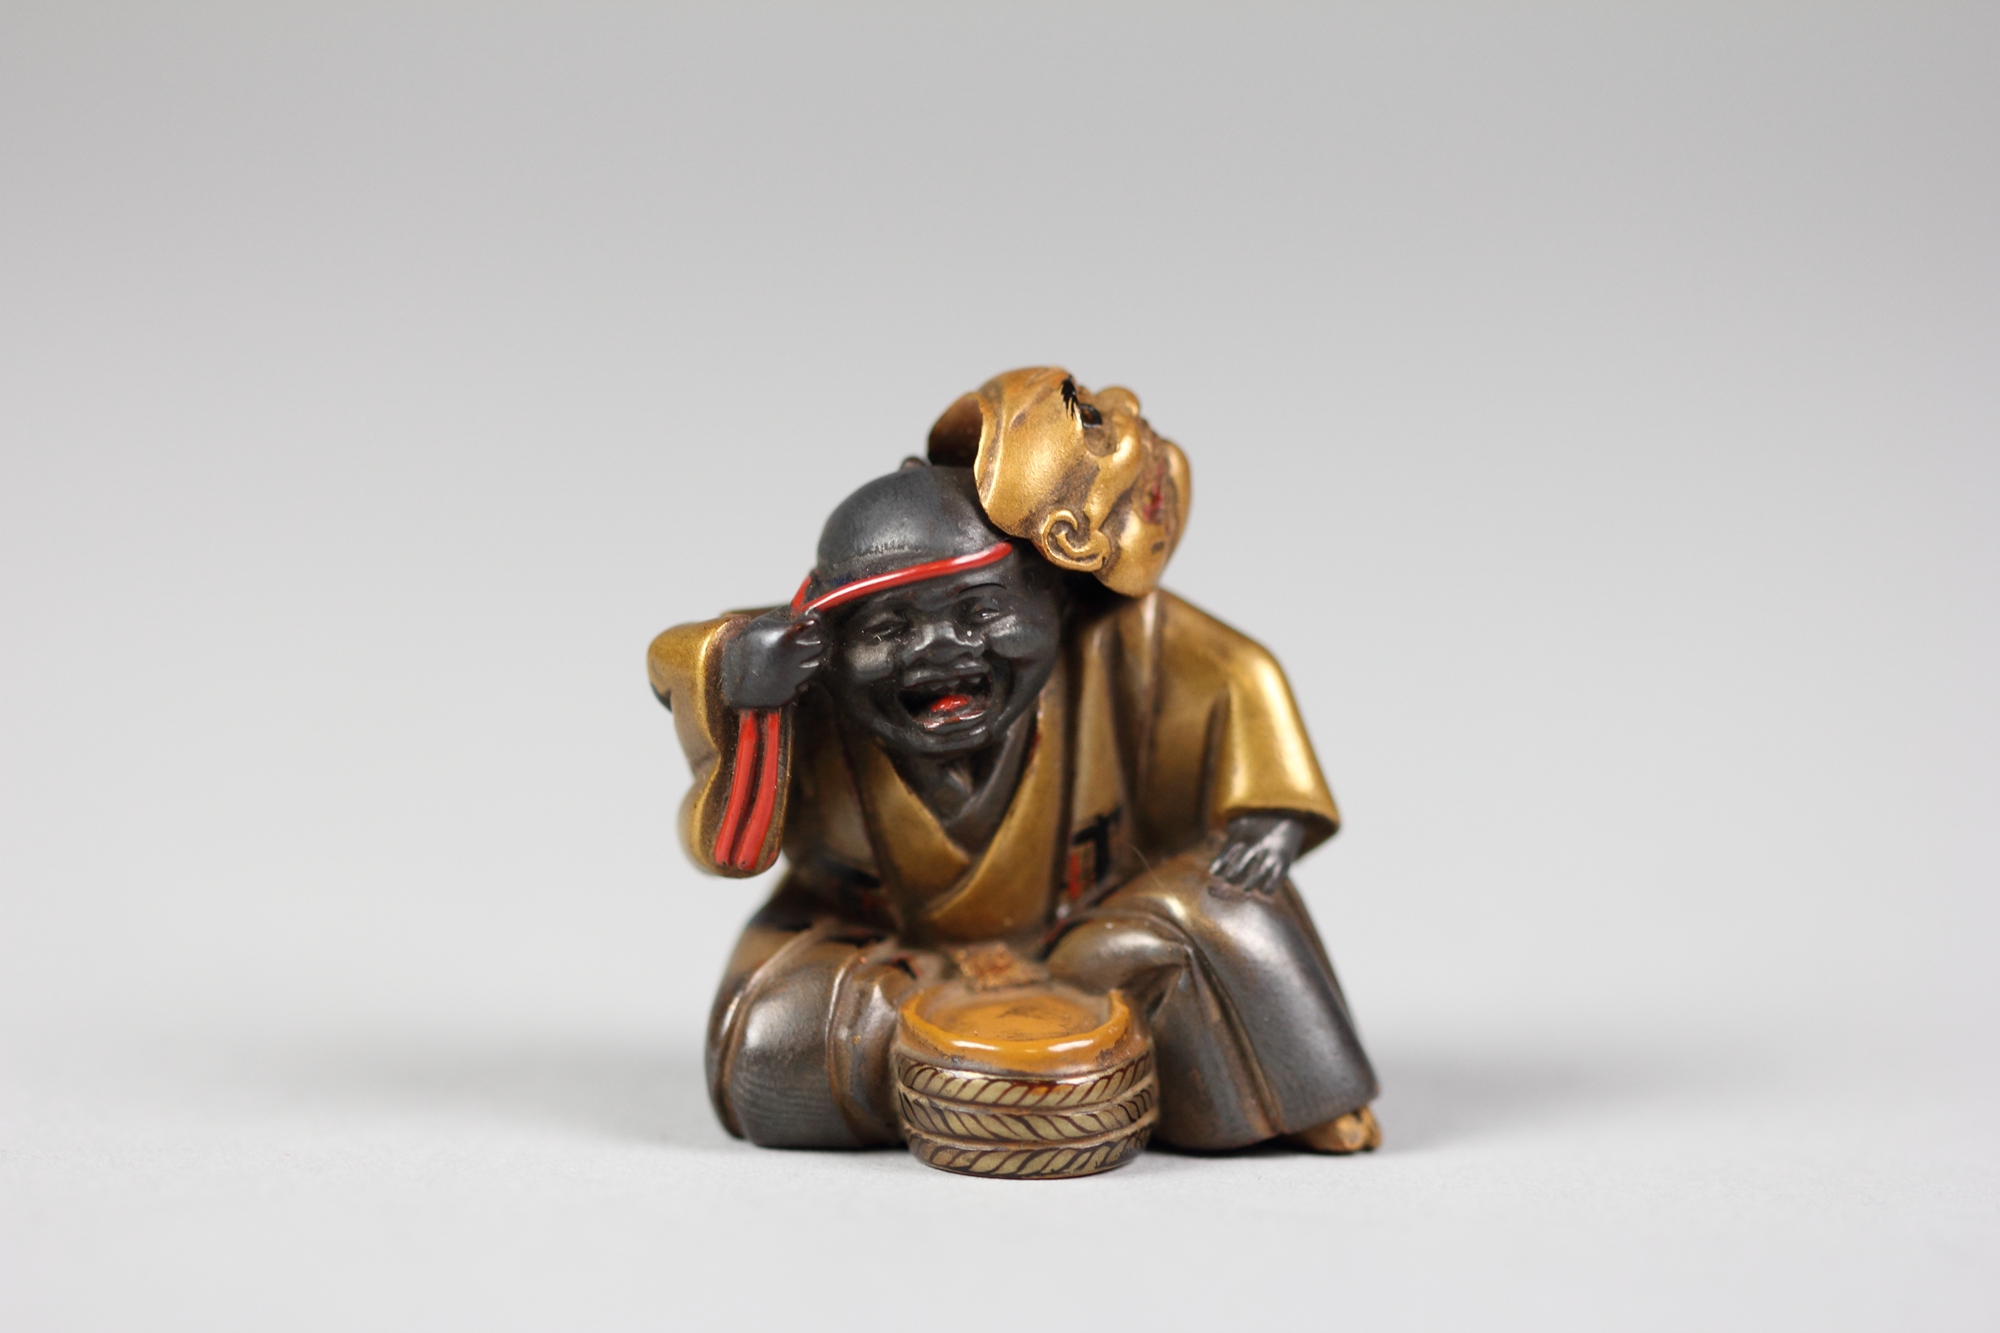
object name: netsuke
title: Netsuke of Boy with a Mask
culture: japanese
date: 1801-1900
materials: lacquer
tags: masks,boys